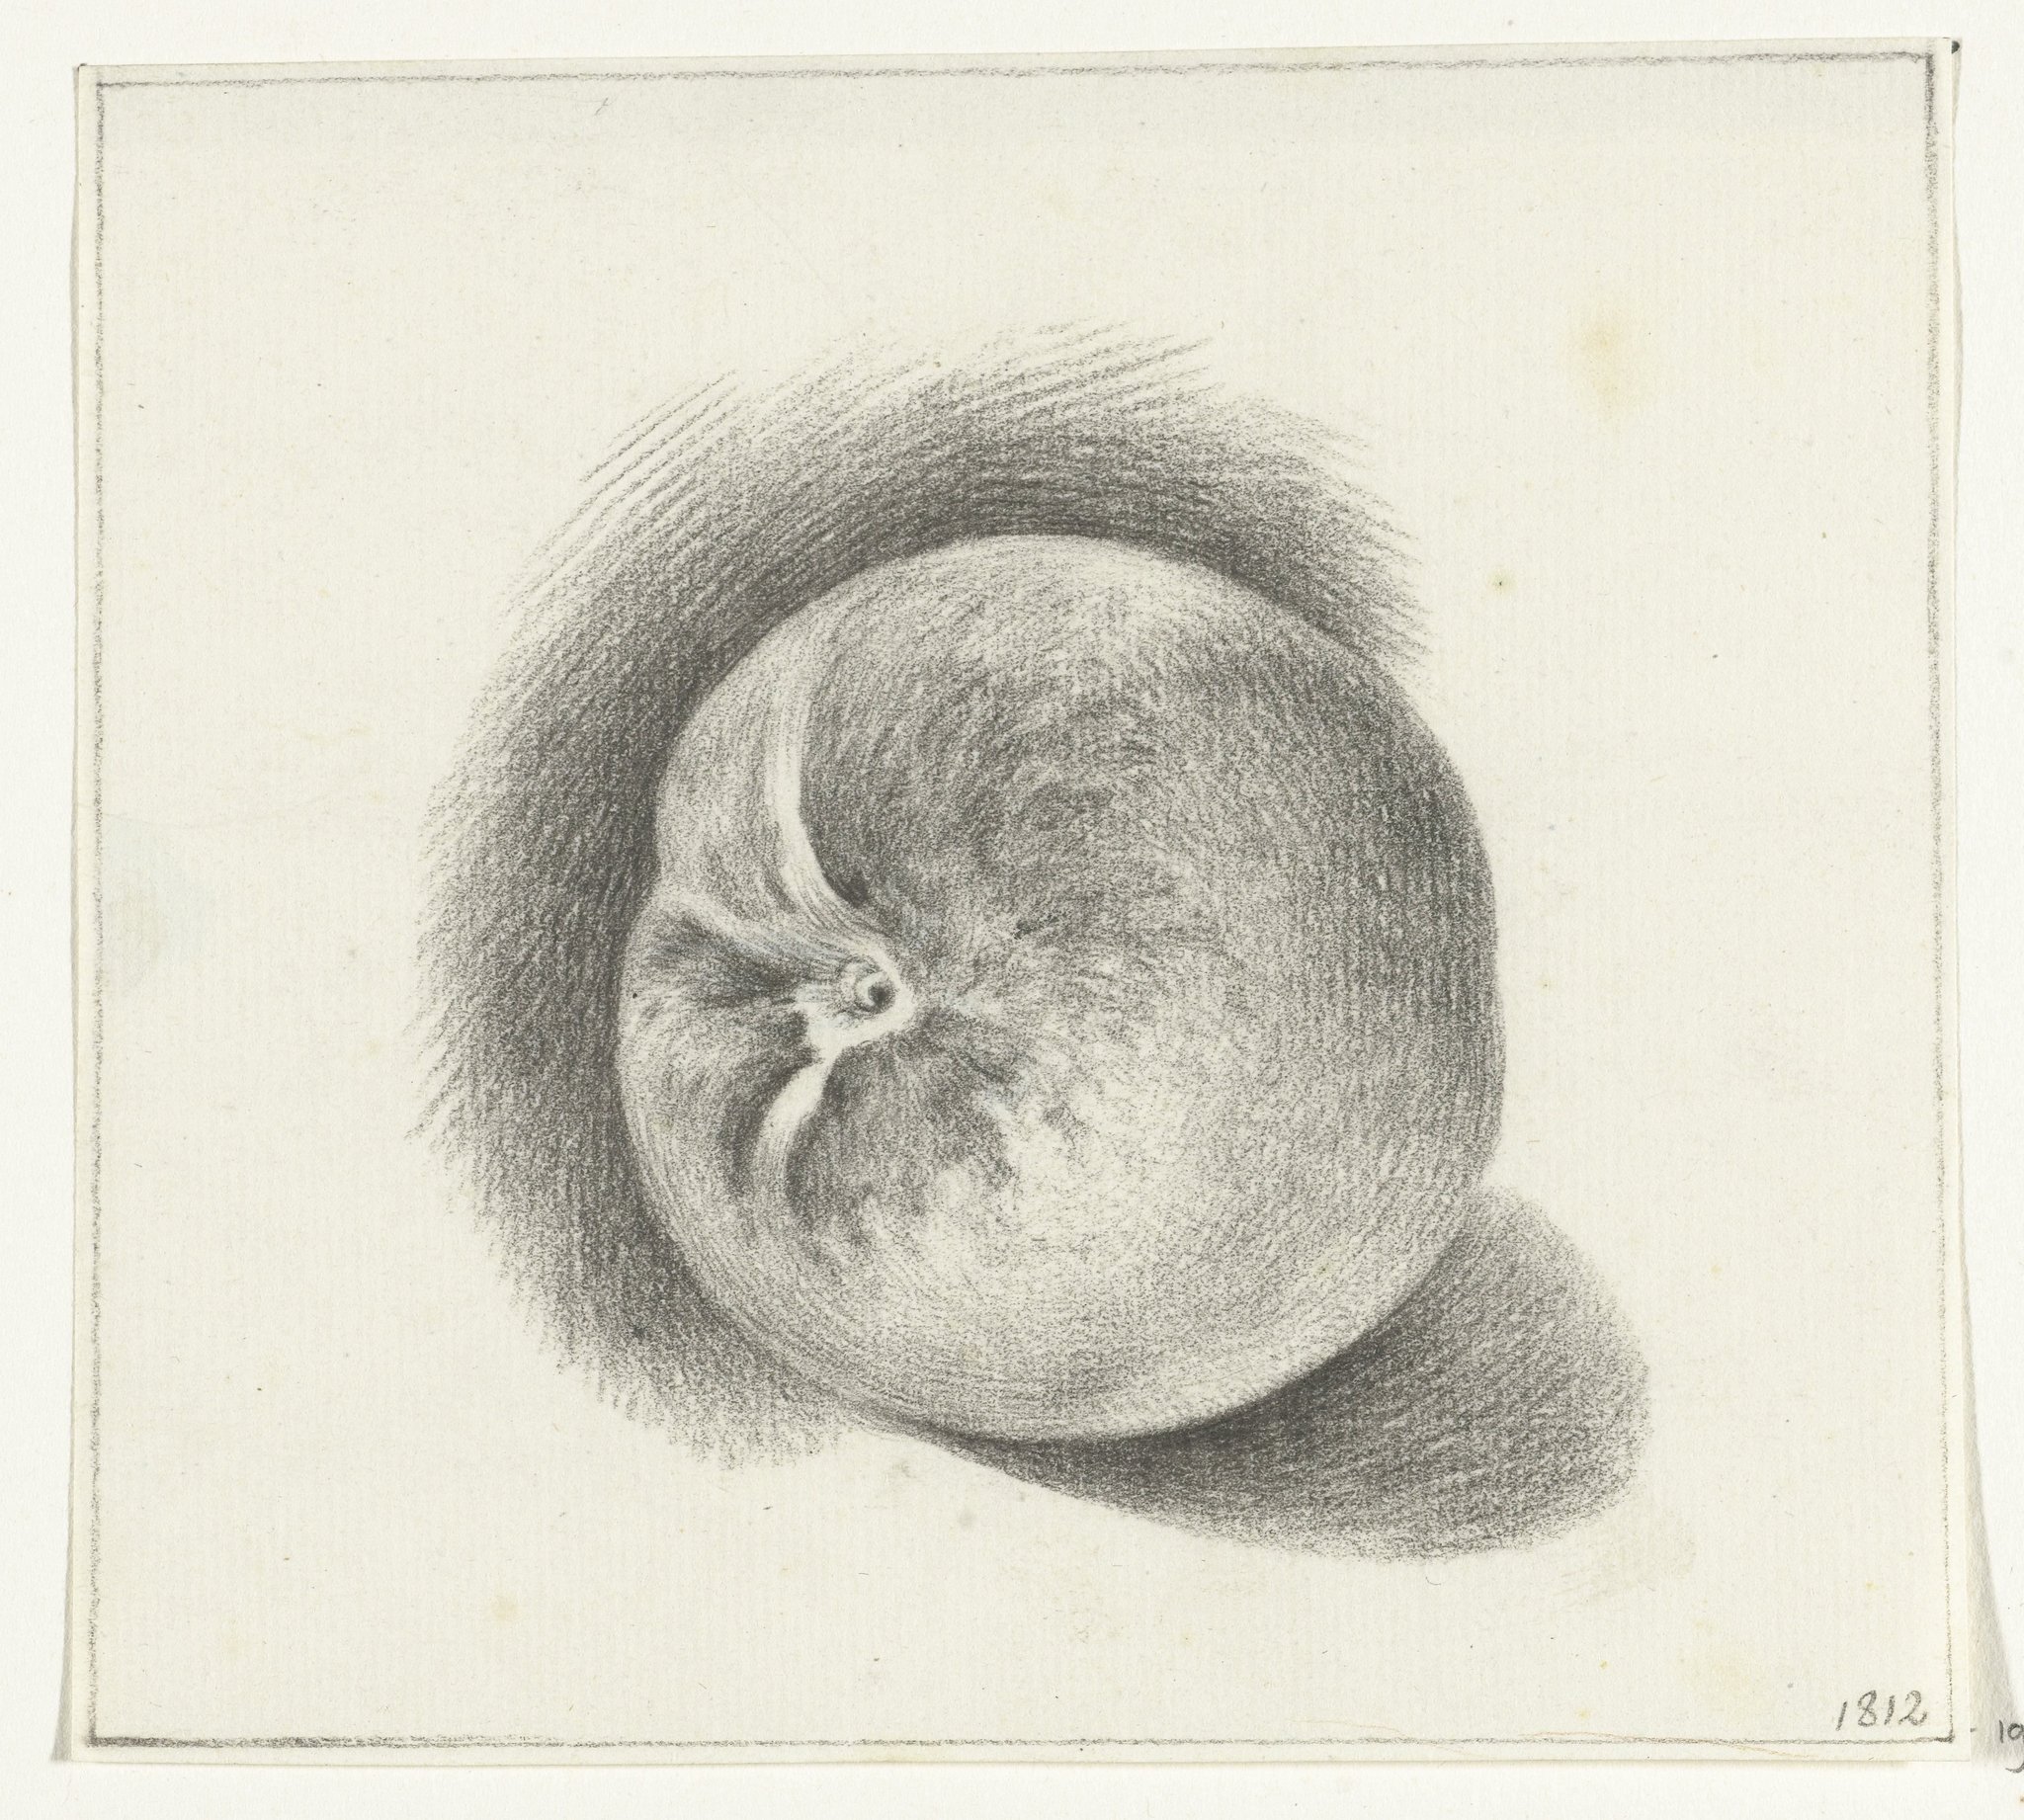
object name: drawing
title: Appel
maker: jean bernard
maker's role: draughtsman, print maker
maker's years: 1765-1833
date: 1812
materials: chalk, paper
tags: fruits: apple